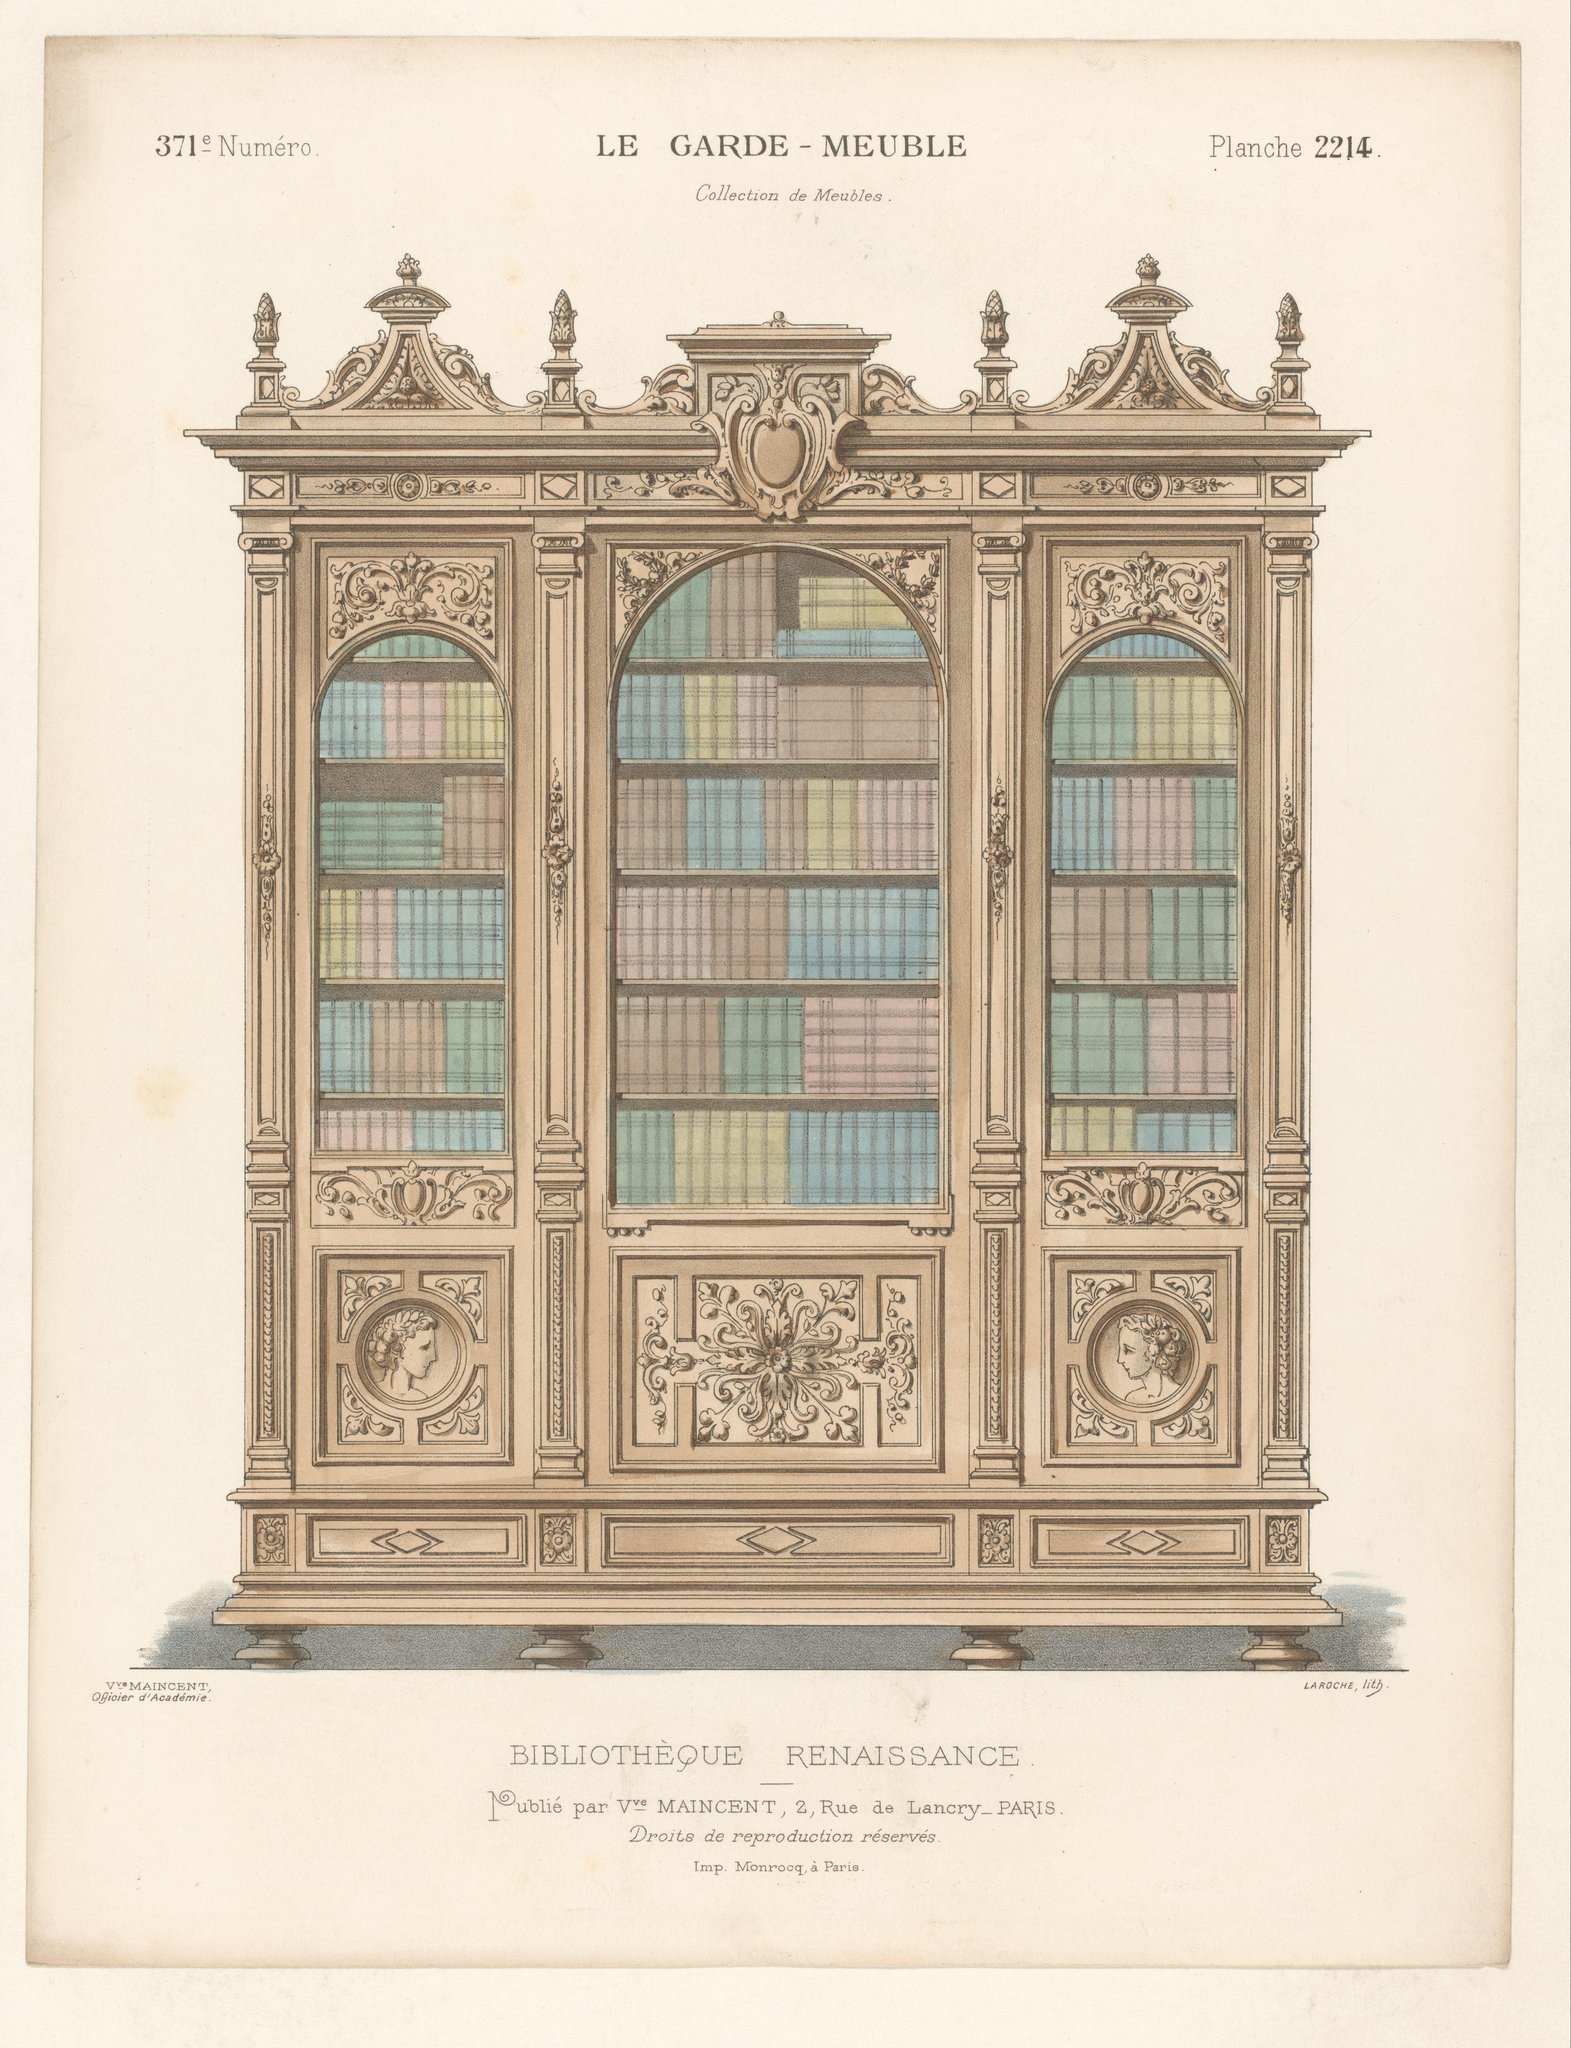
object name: print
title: Bibliothèque renaissance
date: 1895-1935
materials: paper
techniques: hand coloring, lithograph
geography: paris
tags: bookcase, with doors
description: Ieder Livraison in de serie Le Garde-Meuble bevat negen platen: drie 'sièges' (zitmeubels), drie 'meubles' (diverse meubels zoals tafels en kasten) en drie 'tentures' (gordijnen en draperieën).